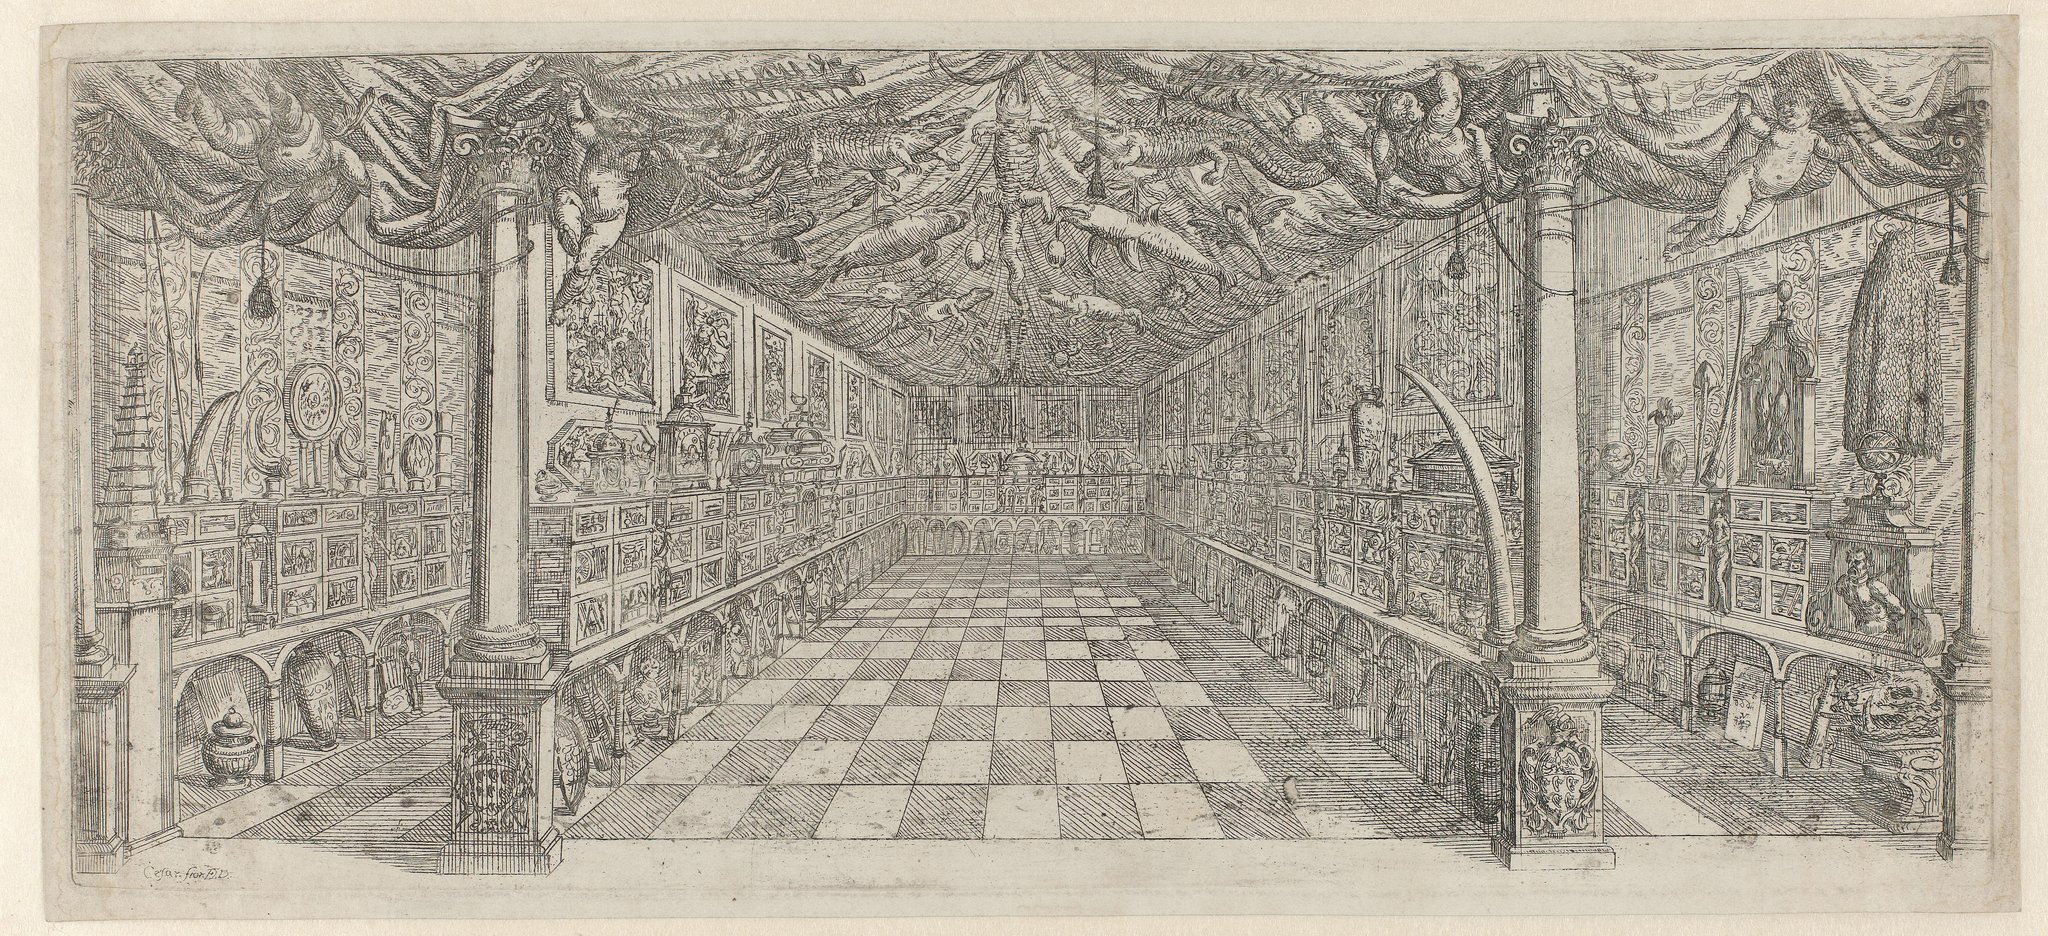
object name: print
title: Manfredo Settala’s Cabinet of Art and Curiosities in Milan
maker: cesare fiori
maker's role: draughtsman, painter, print maker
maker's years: 1636-1702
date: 1666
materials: paper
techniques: etching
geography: italy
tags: cabinet of curiosities, 'kunst- und wunderkammer'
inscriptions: collector's mark: Lugt 2760, collector's mark: Lugt 2228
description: In the space depicted here, every centimetre is used for the presentation of a wide variety of objects. Distinguished visitors of this 17th-century cabinet of art and curiosities must have been awed; it was like walking through an encyclopaedia. Fiori made the print to illustrate a book about the private collection of the Milanese clergyman Manfredo Settala.